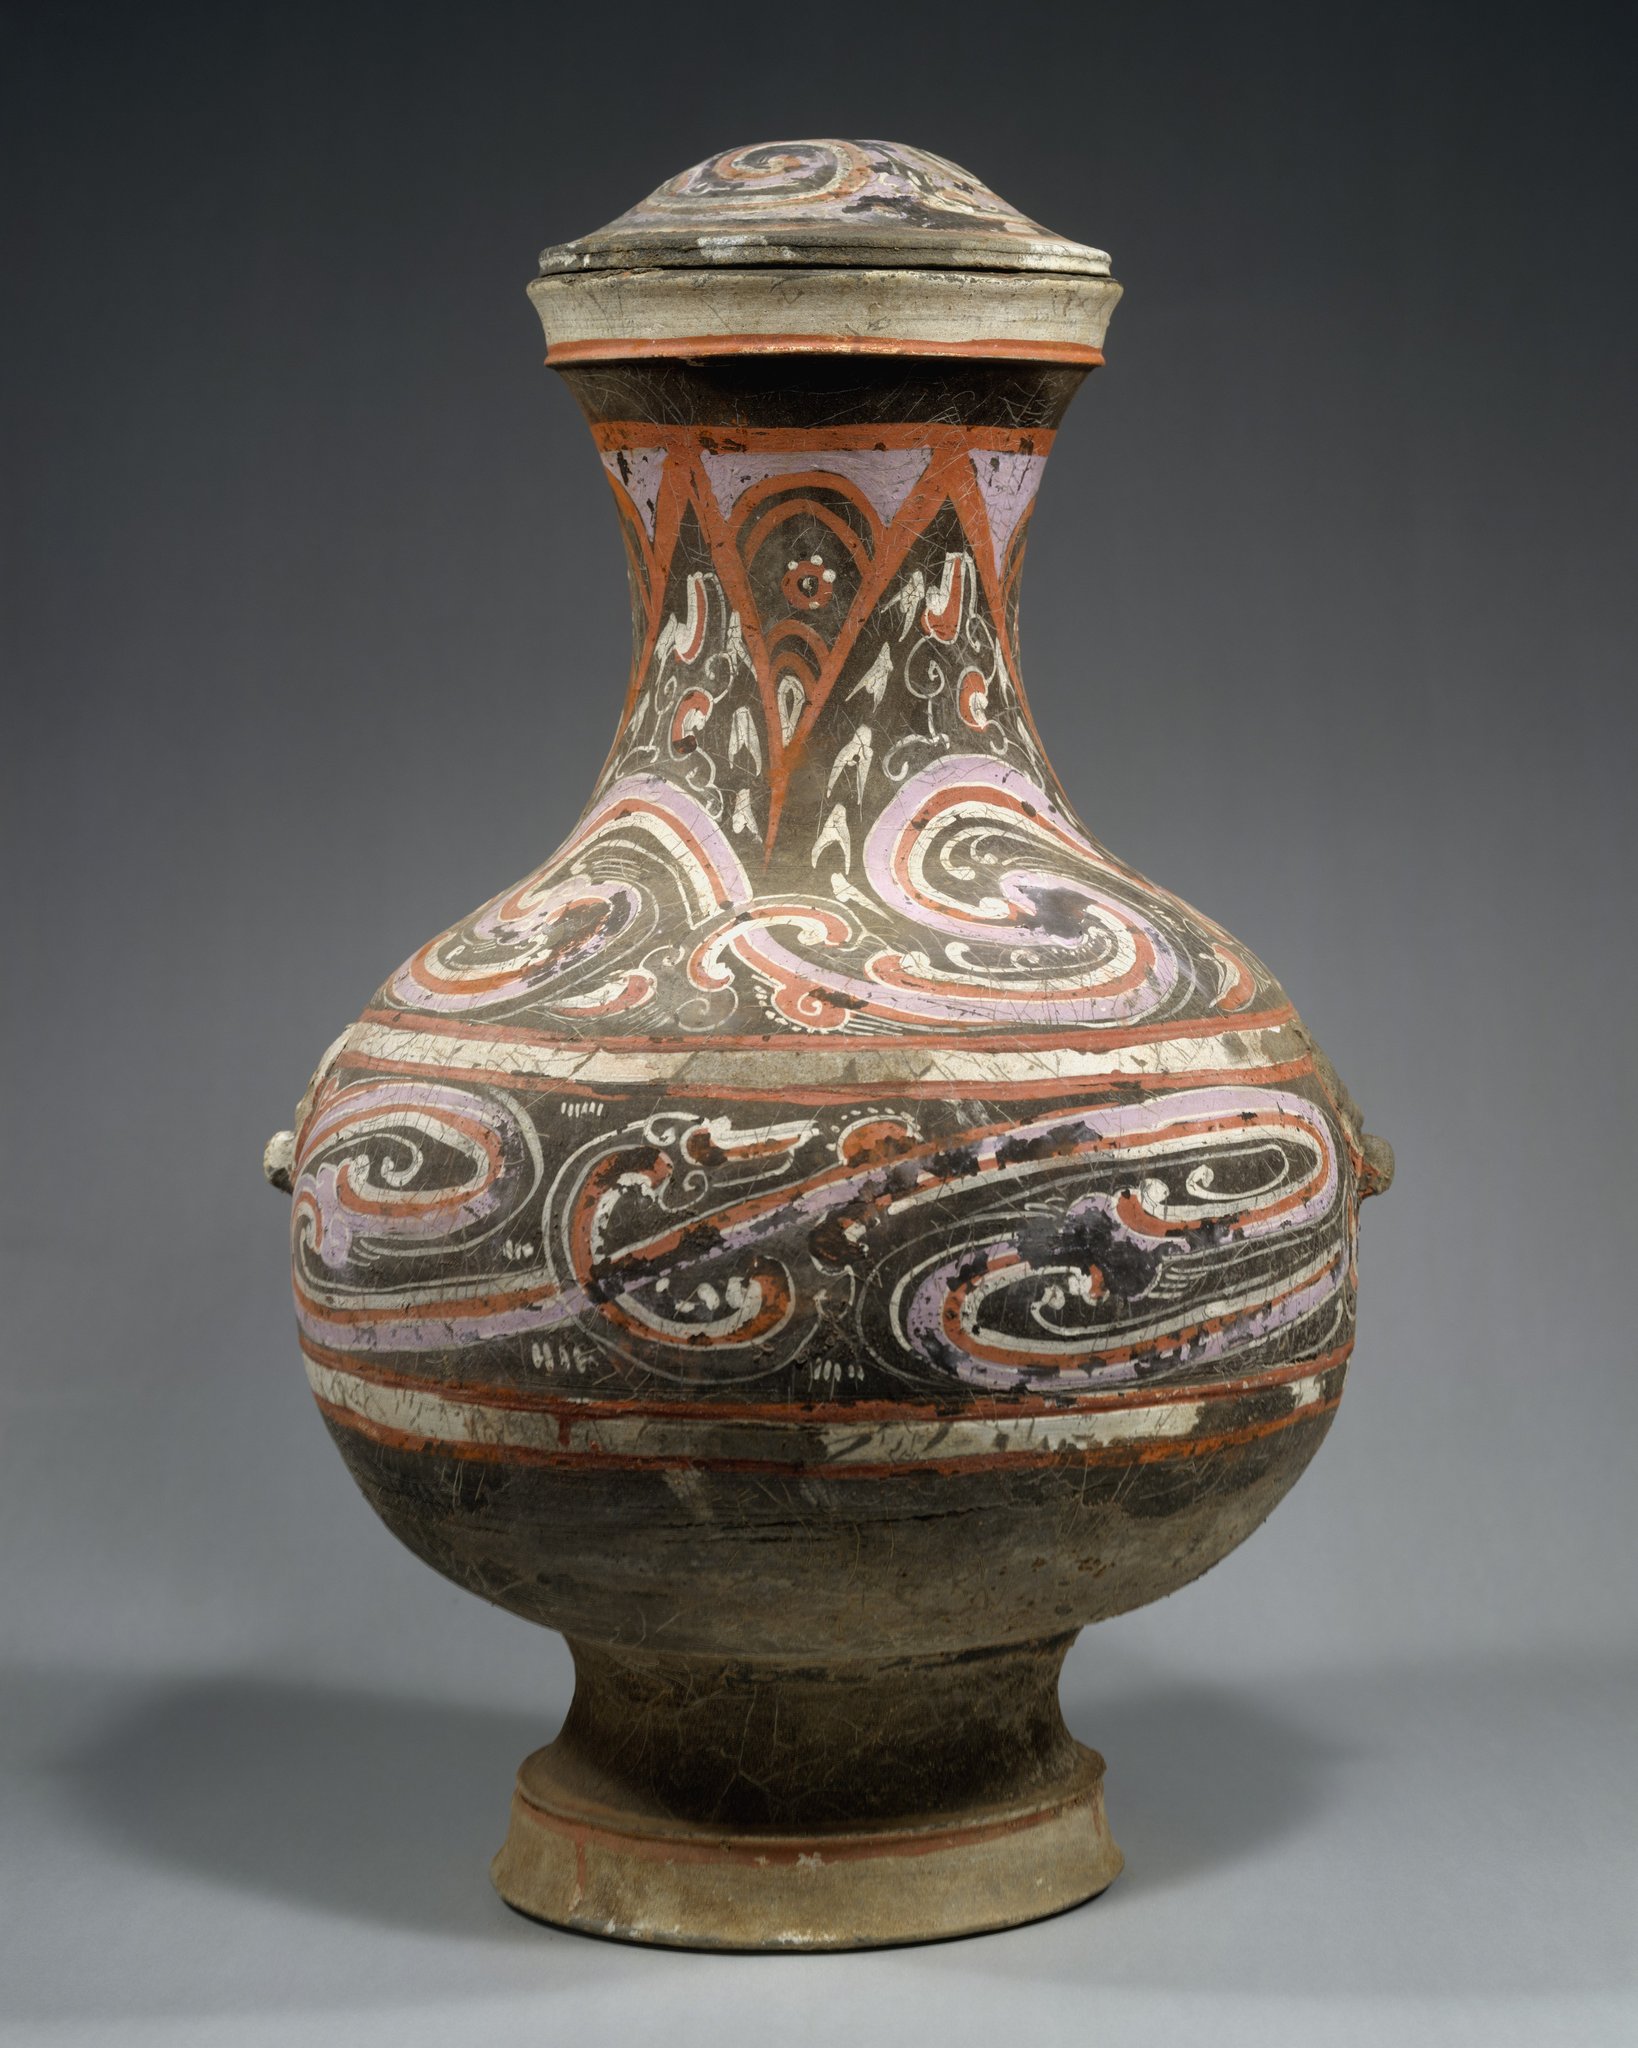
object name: jar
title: Covered Jar (Hu)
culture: chinese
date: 100-1 BCE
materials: earthenware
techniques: painting